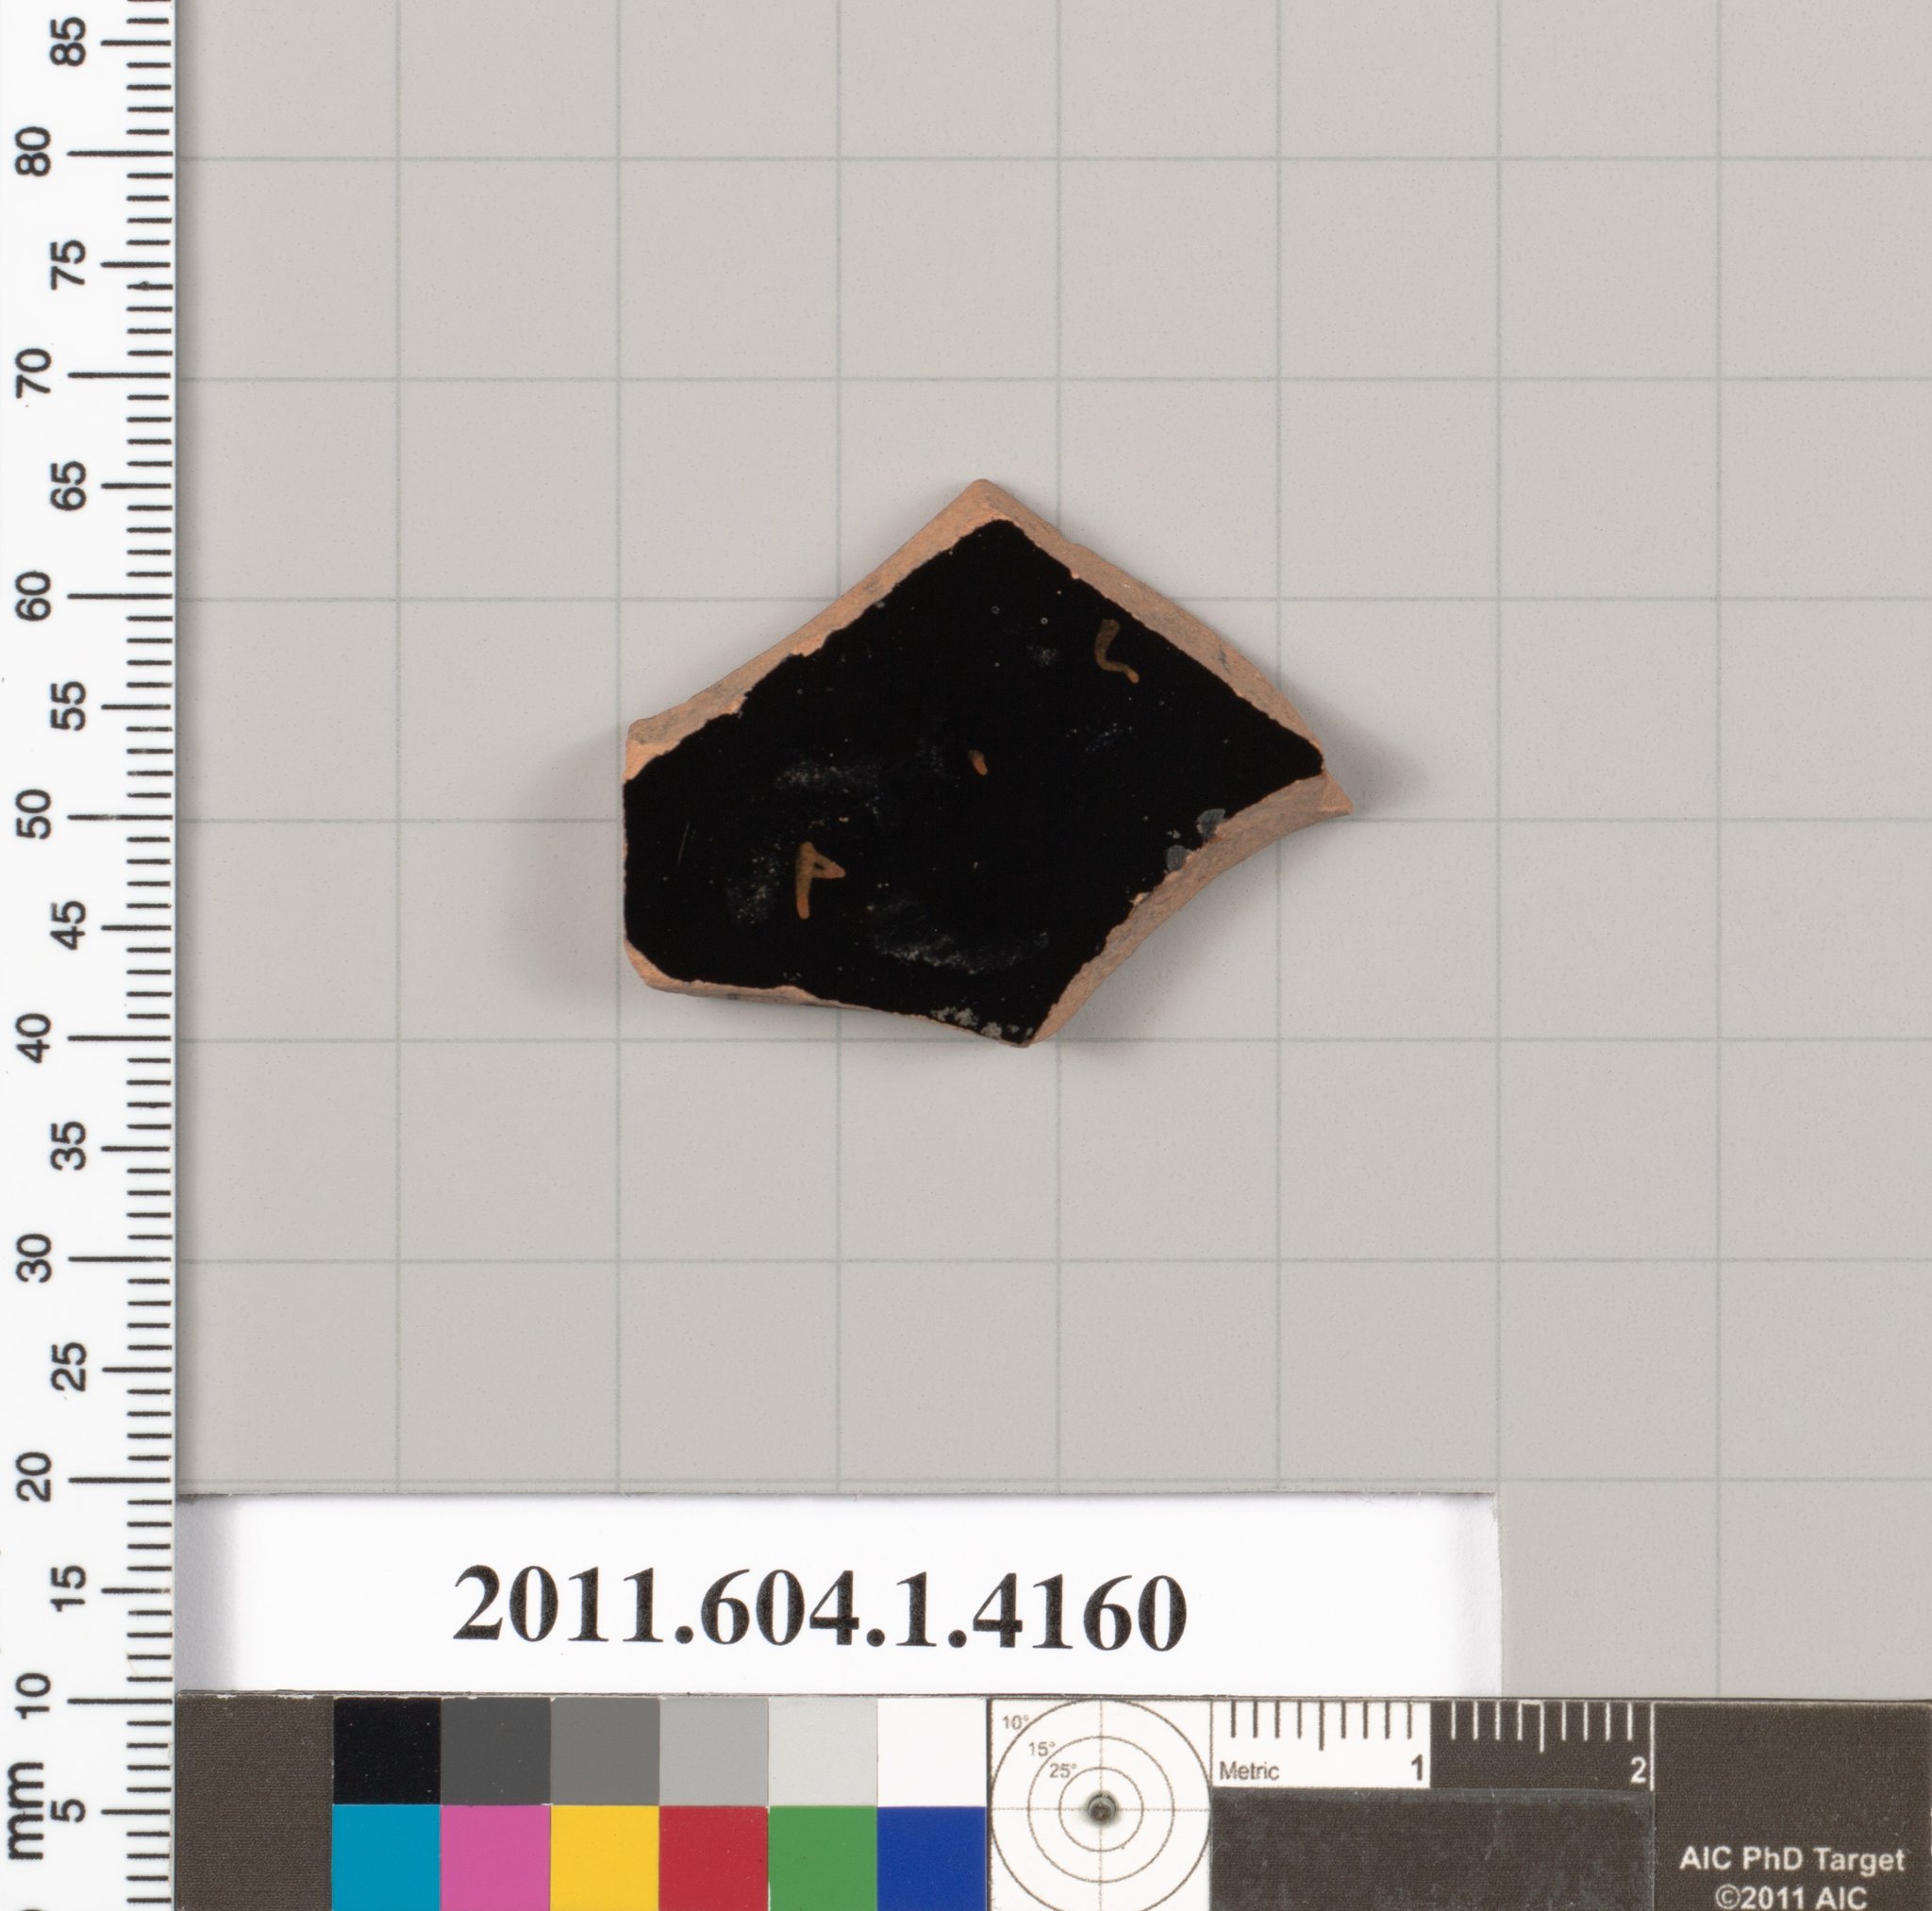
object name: kylix fragment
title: Terracotta fragment of a kylix (drinking cup)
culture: greek, attic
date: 490-470 BCE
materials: terracotta